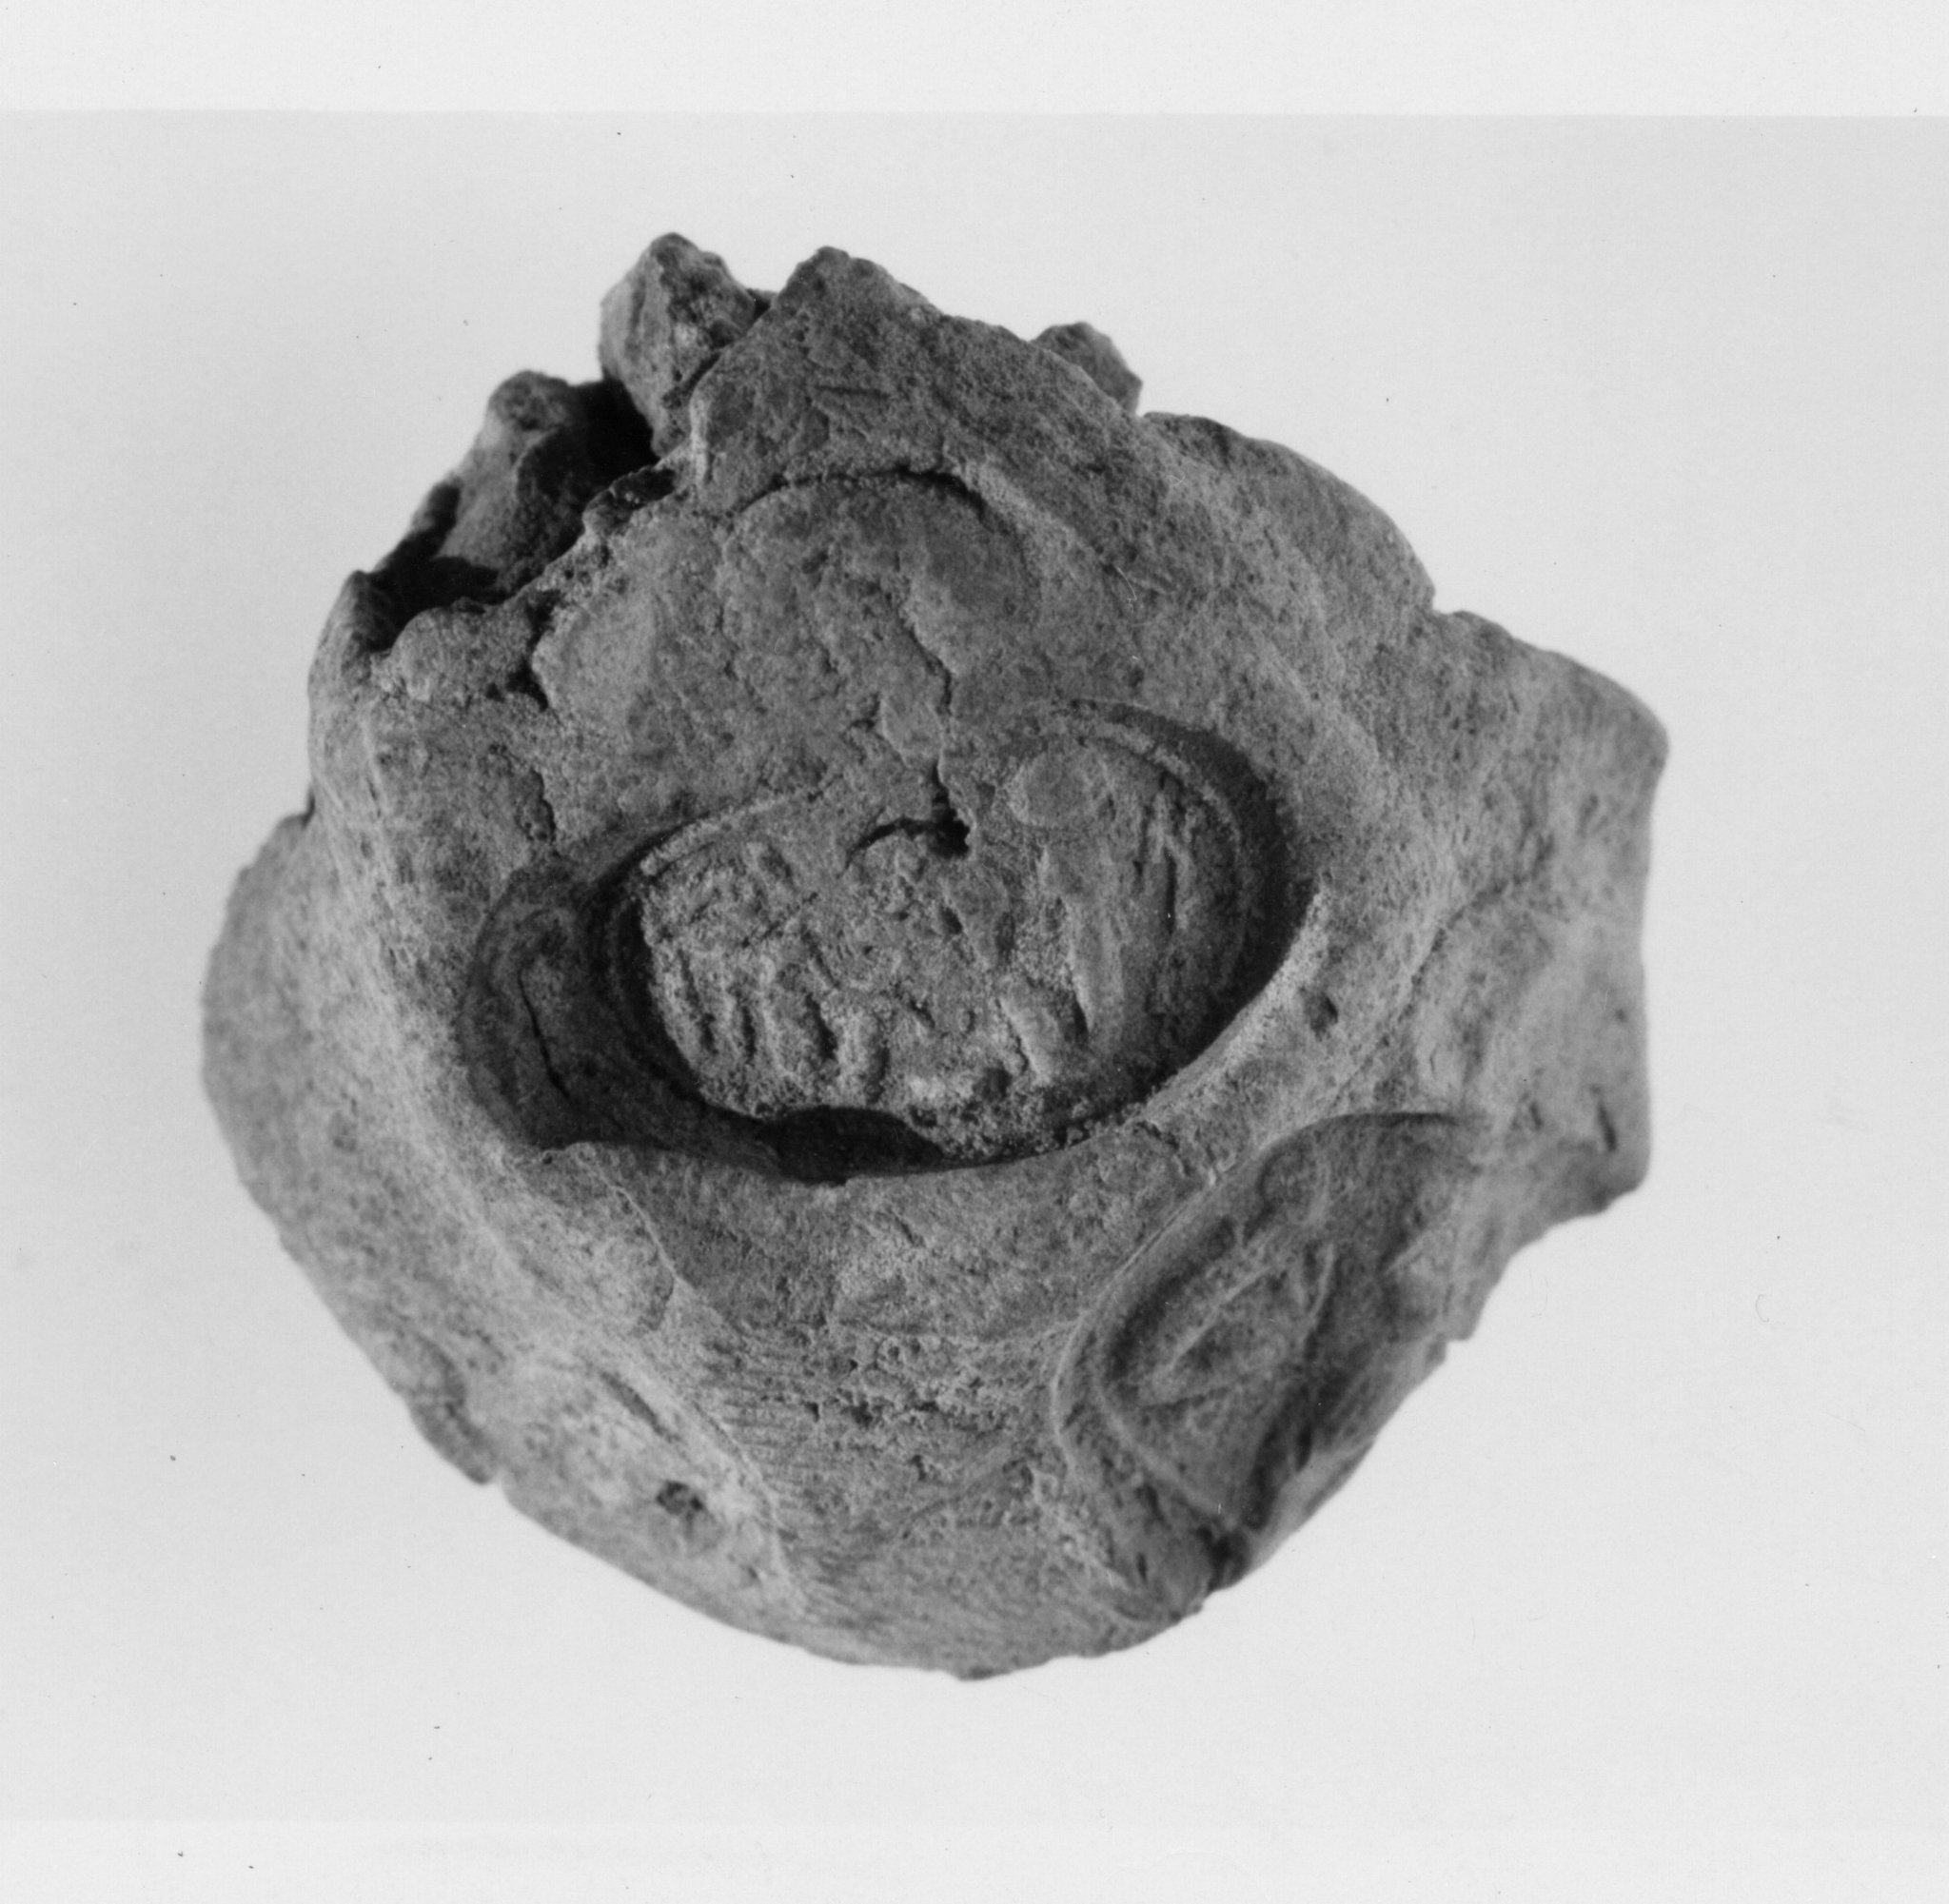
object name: sealing, nebmaatre, amenhotep iii, heb sed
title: Document Sealing With Multiple Seal Impressions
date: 1390-1352 BCE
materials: mud